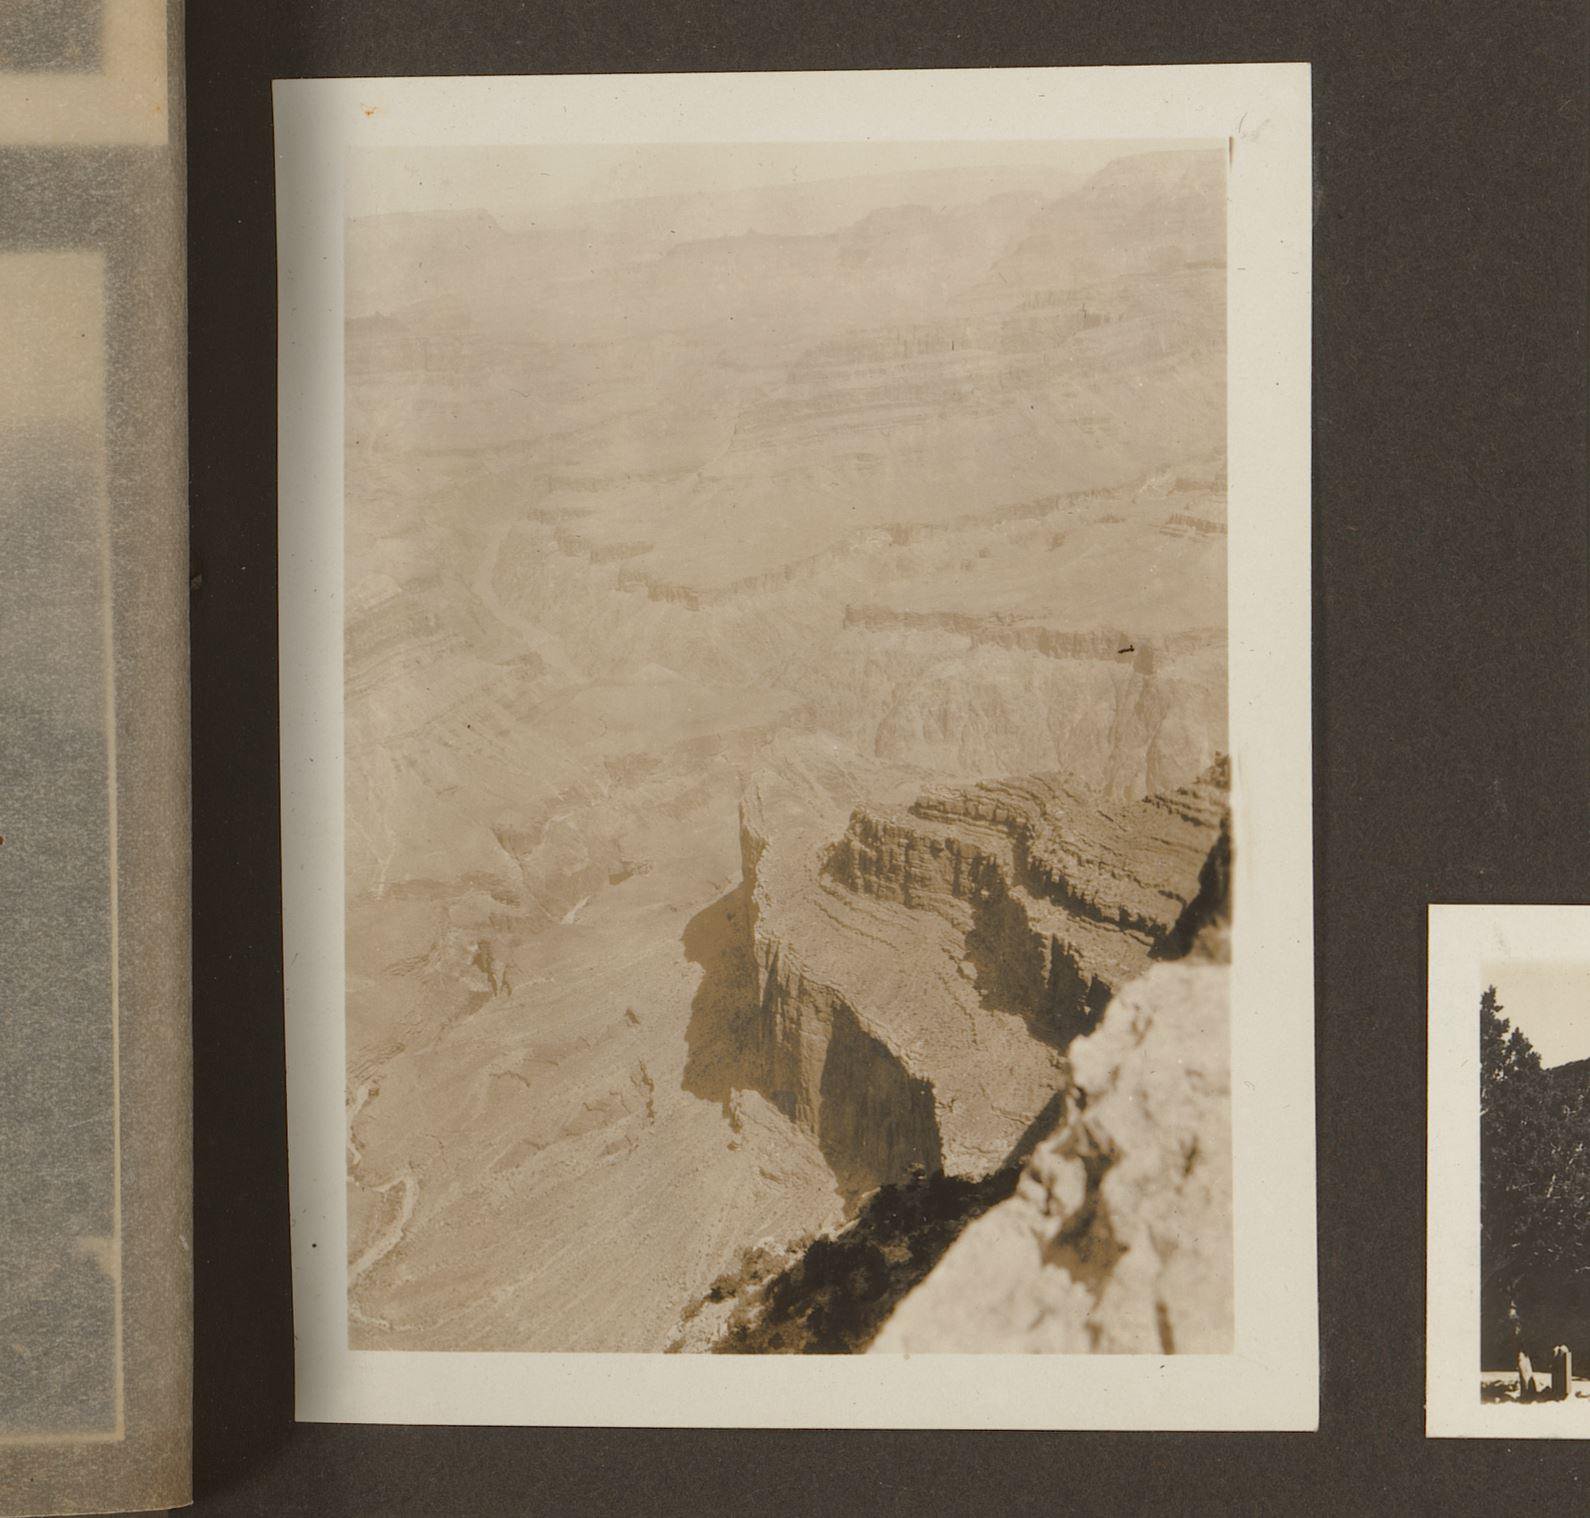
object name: album leaf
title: Uitzicht over de Grand Canyon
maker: Anonymous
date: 1928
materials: photographic support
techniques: gelatin silver print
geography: grand canyon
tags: open hearth, fire-place, interior of the house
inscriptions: annotation: ‘Grand Canyon’